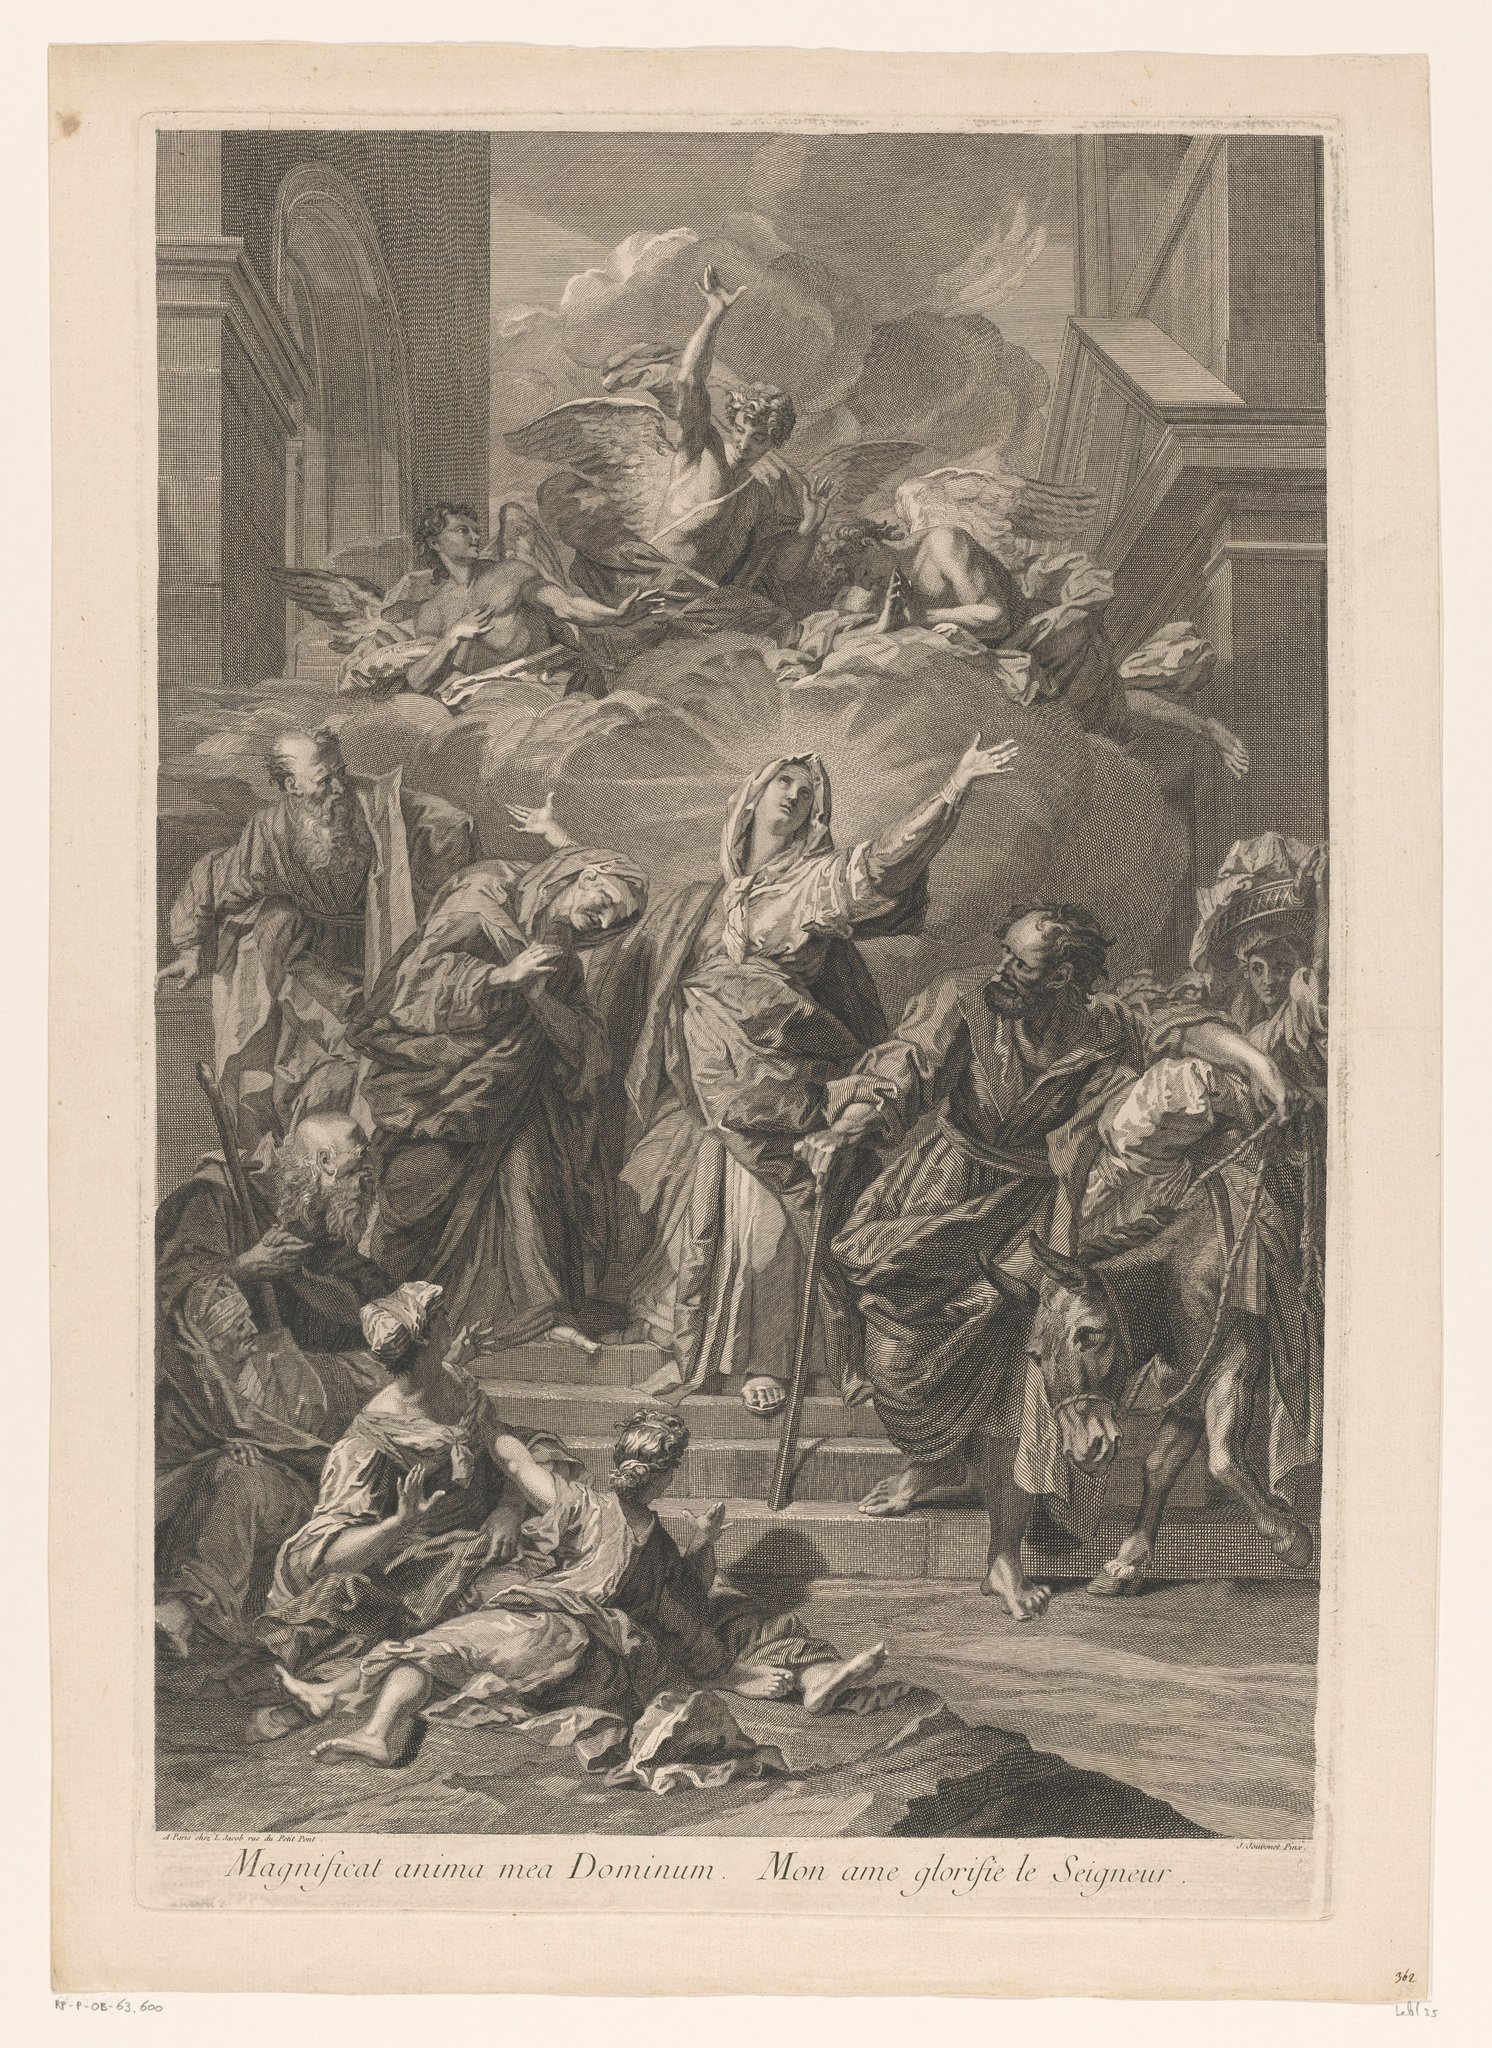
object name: print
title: Magnificat anima mea Dominum. Mon ame glorifie le Seigneur (mijn ziel prijst de heer)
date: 1697-1741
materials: paper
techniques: engraving, etching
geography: paris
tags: mary magnifying the lord ('magnificat')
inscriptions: number: ‘362’